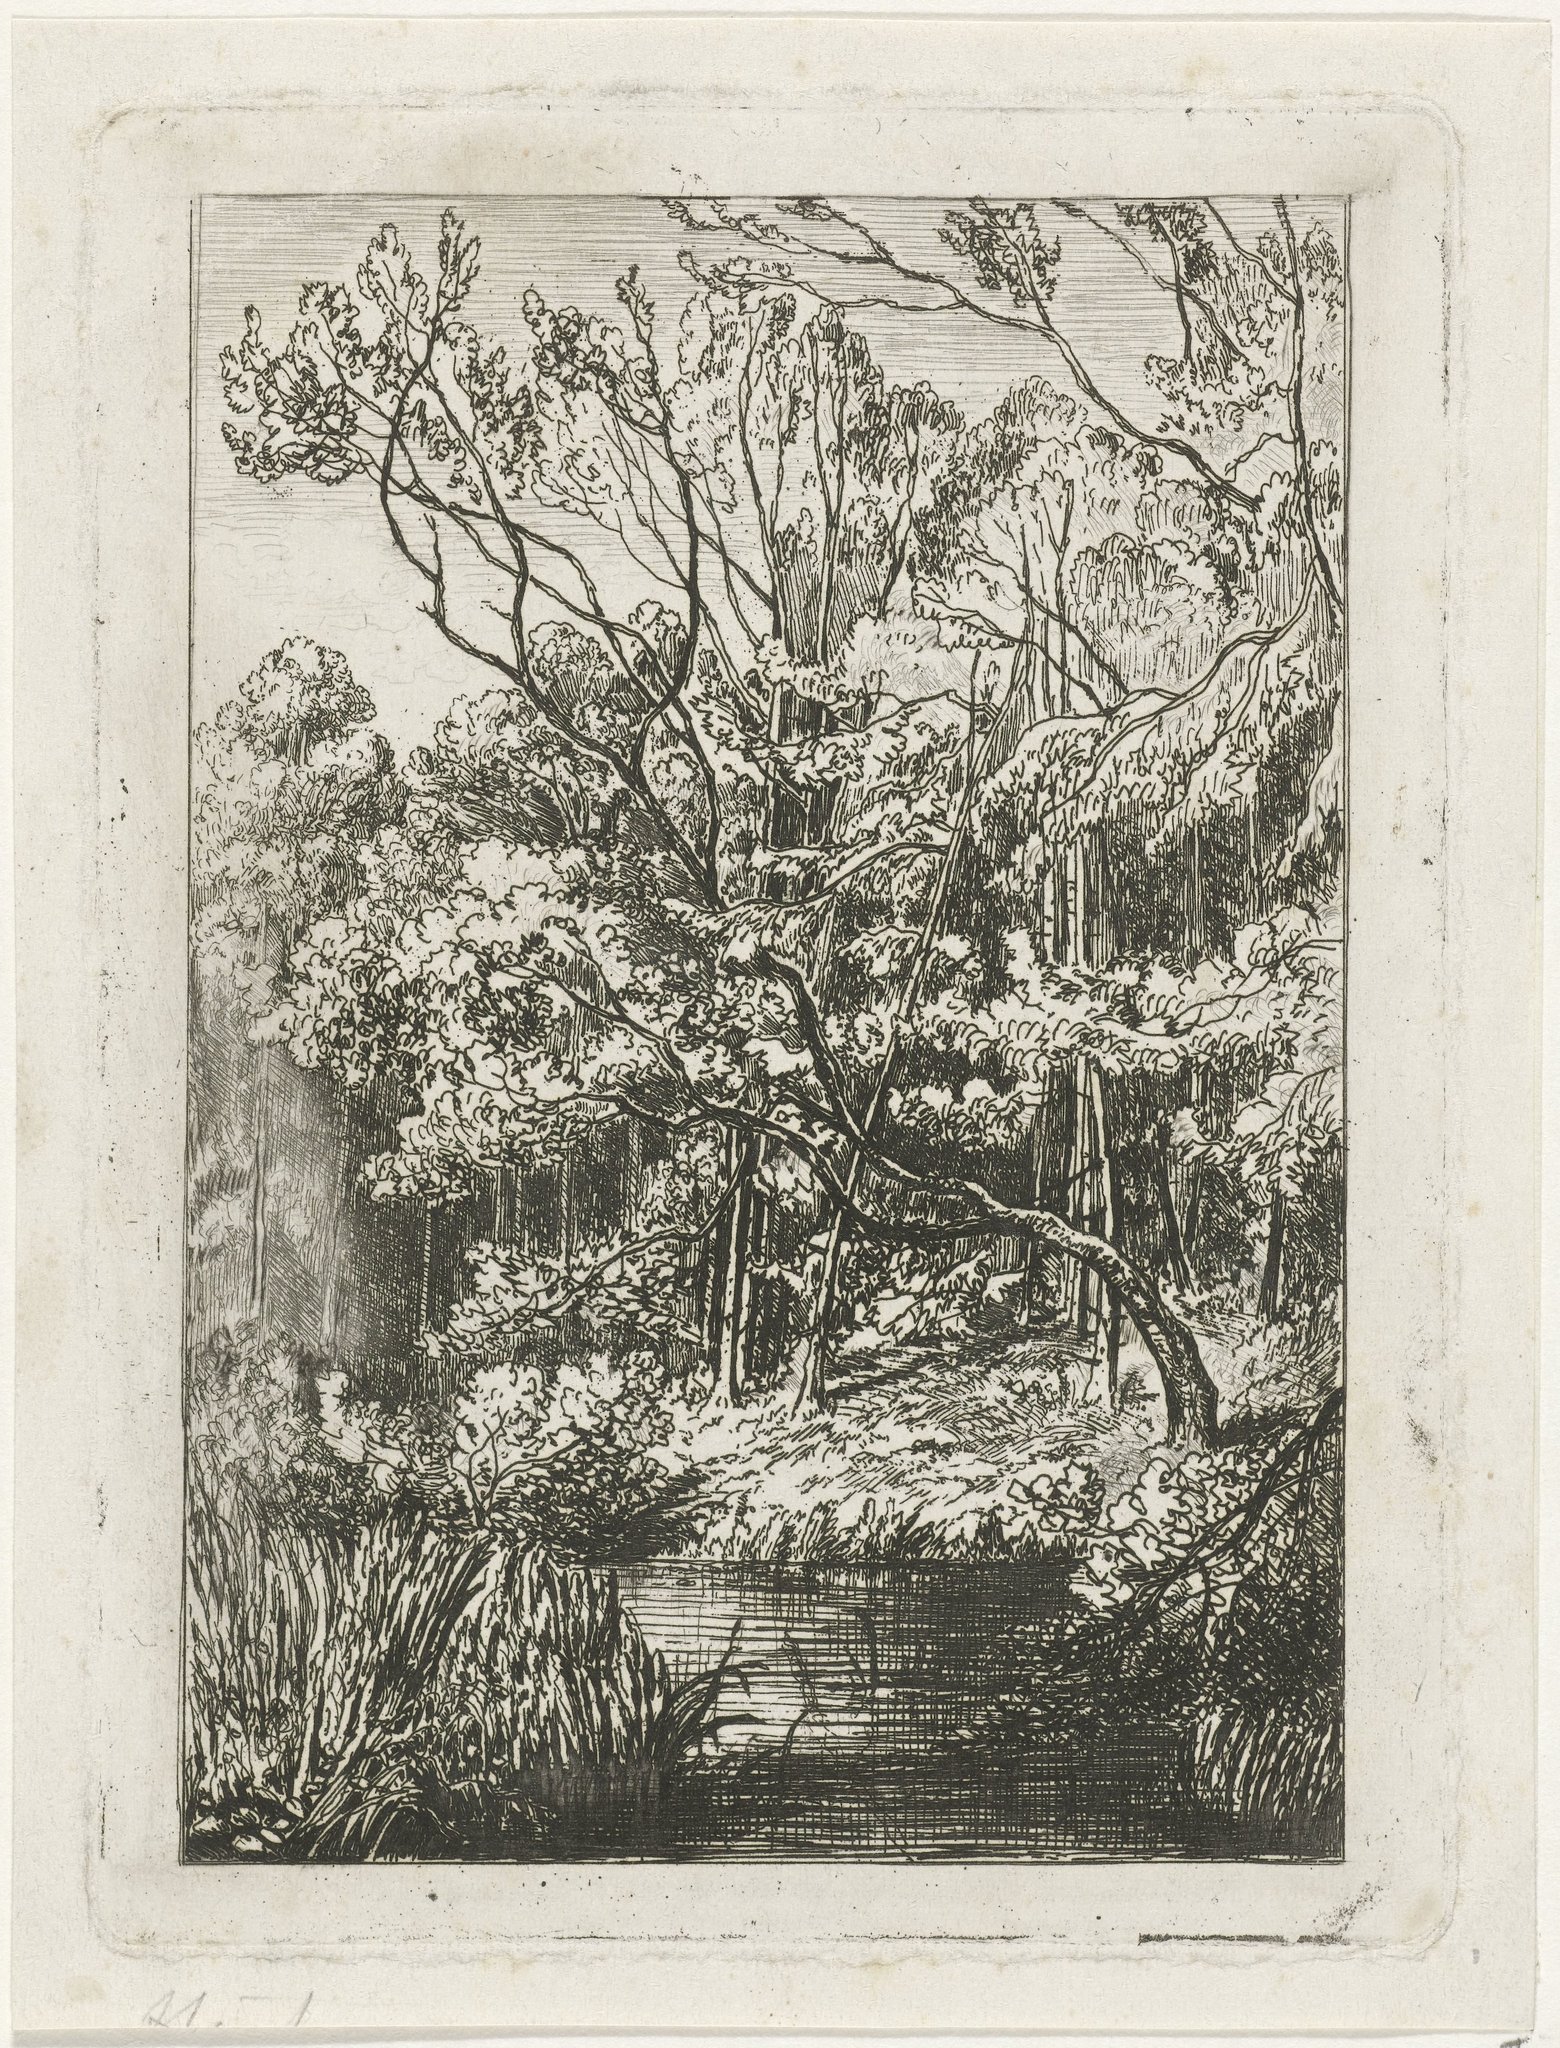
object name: print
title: Bosgezicht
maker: joseph hartogensis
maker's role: painter, print maker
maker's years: 1822-1865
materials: paper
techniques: drypoint, etching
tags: water course, forest, wood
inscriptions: collector's mark: Lugt 2228